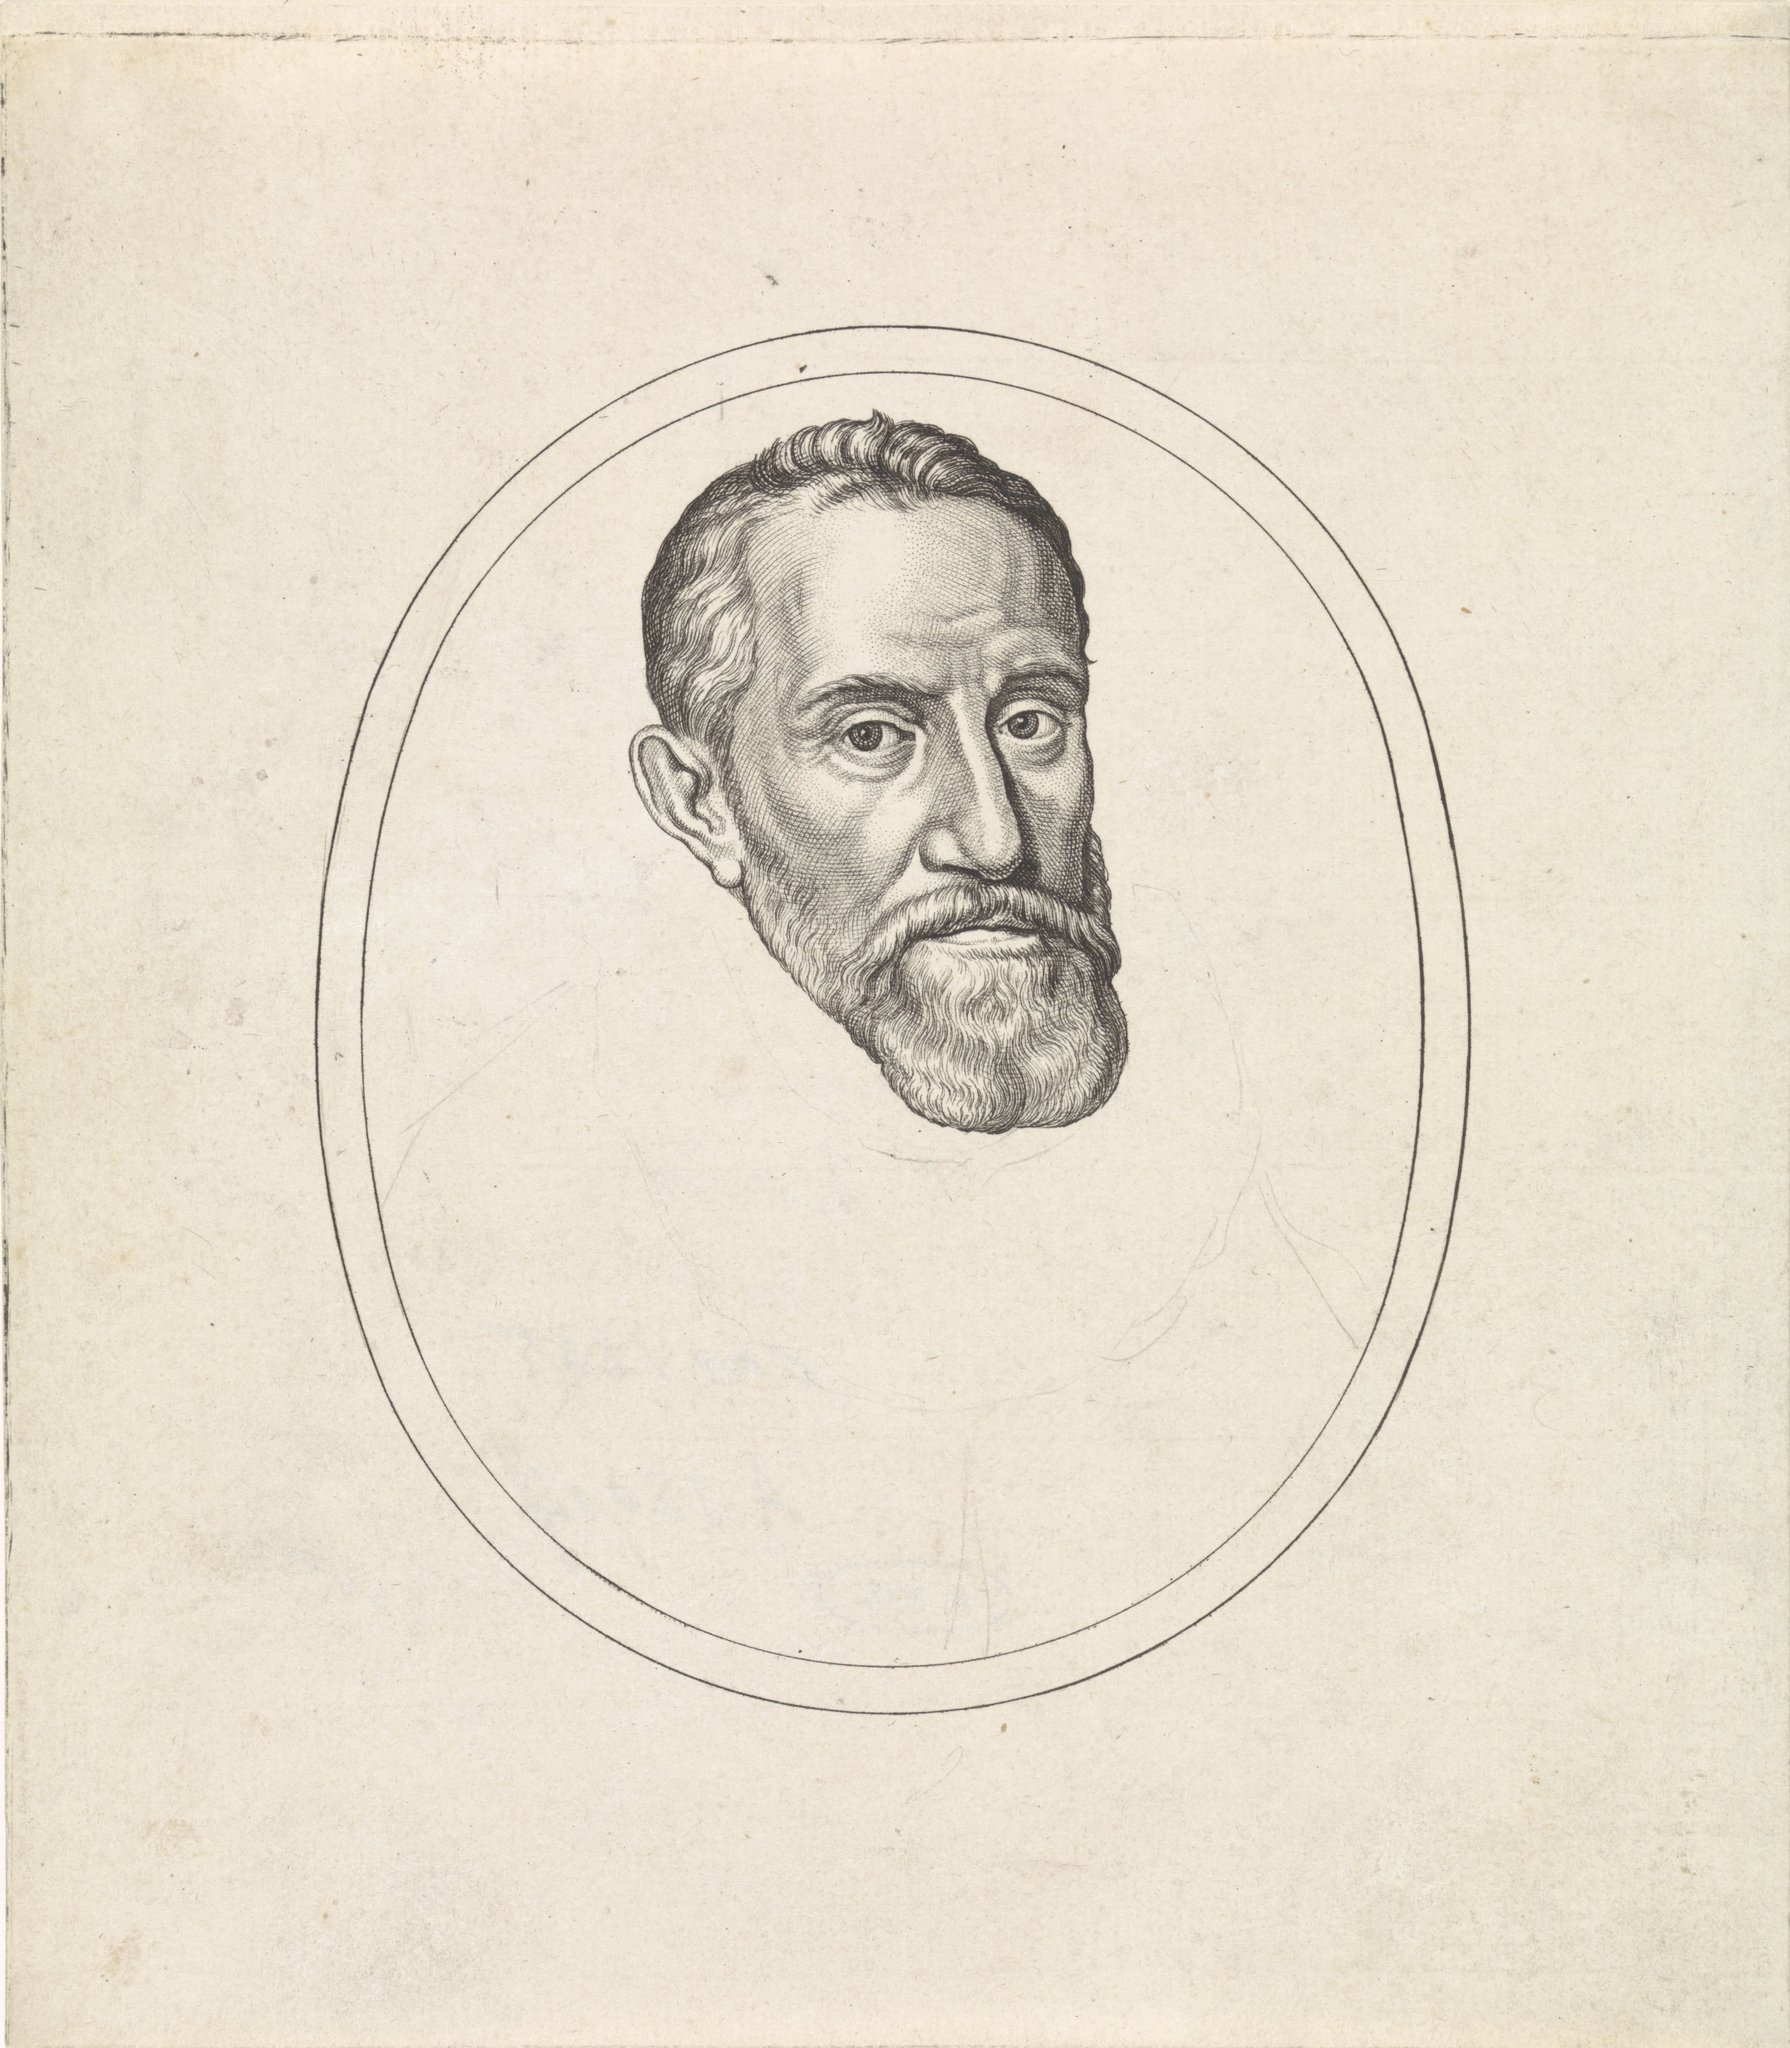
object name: print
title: Portret van een man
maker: simon van de passe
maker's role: print maker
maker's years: 1595-1647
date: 1574-1637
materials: paper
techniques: engraving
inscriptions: collector's mark: Lugt 2228